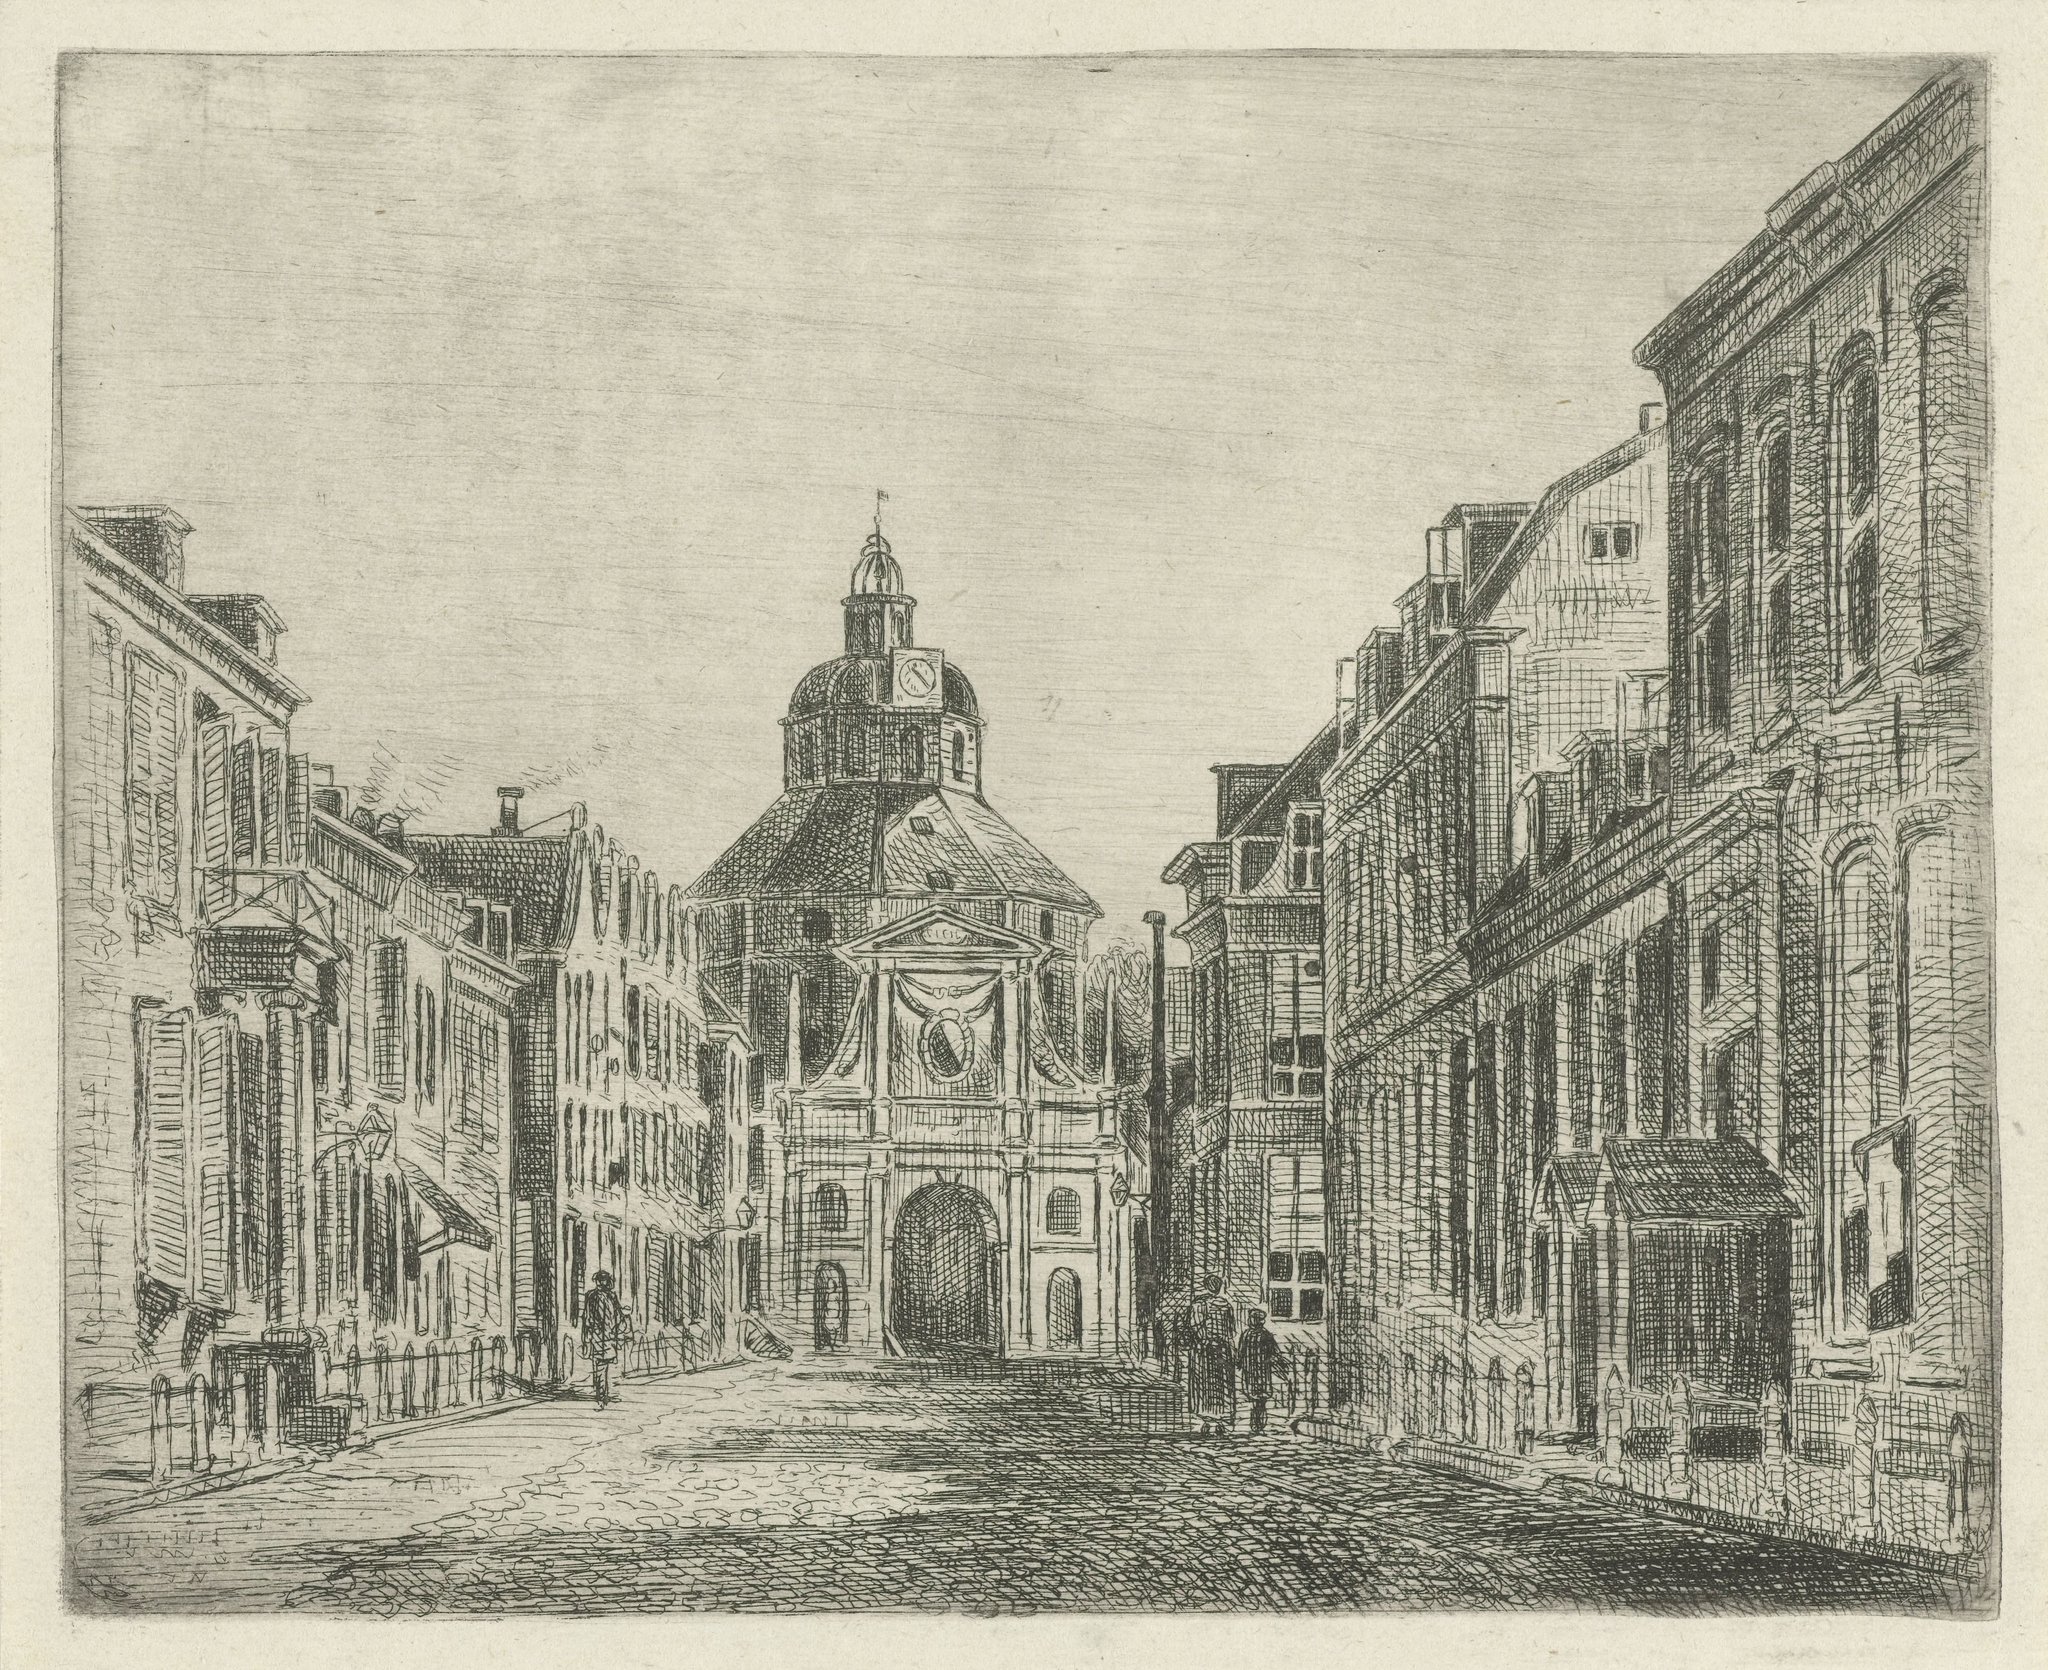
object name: print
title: Gezicht op de Wittevrouwenpoort te Utrecht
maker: jan van lokhorst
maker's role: draughtsman, print maker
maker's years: 1837-1894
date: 1847-1874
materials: paper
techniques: etching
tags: street, city-gate (+ city(-scape) with figures, staffage)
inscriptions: collector's mark: Lugt 2228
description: De Wittevrouwenpoort te Utrecht, gezien vanuit de stad. Links en rechts lopen enkele passanten op de stoep.